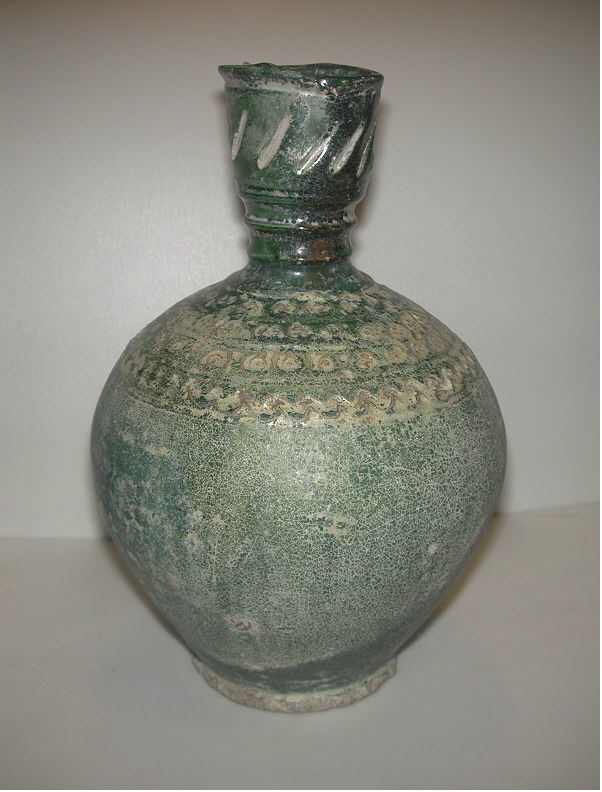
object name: bottle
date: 901-1000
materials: earthenware, engobe, glaze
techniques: incising, stamping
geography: iran